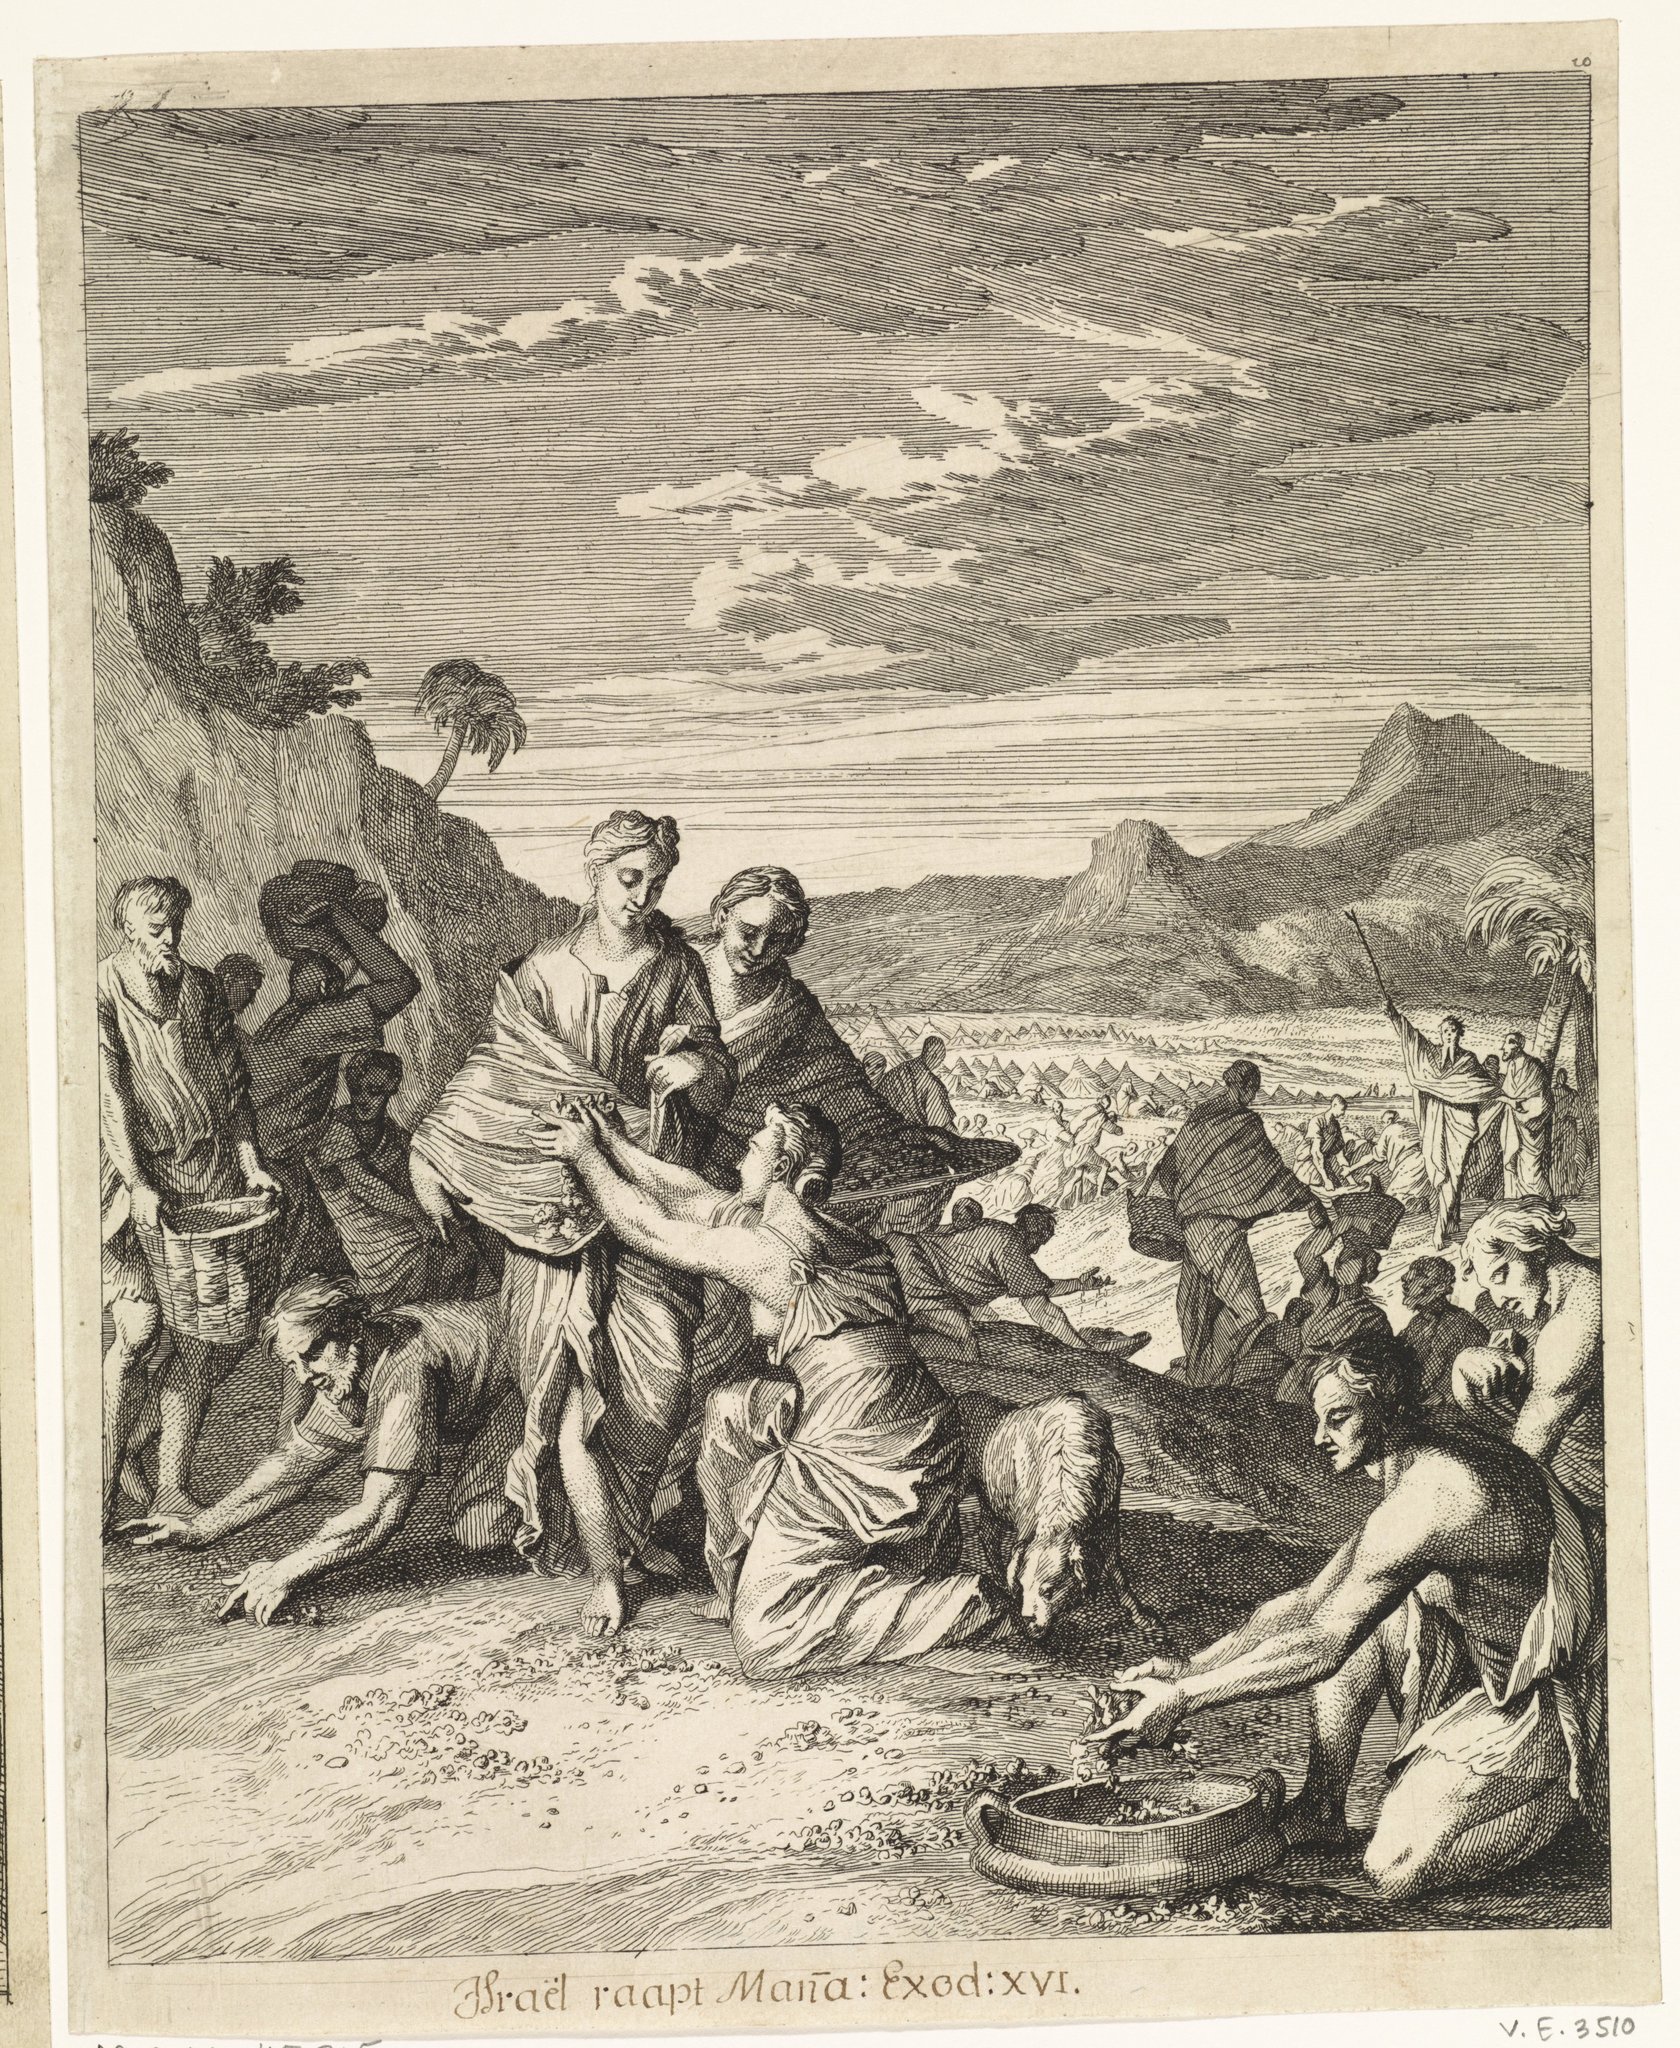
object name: print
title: Inzameling van het manna door de Israëlieten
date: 1708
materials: paper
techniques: etching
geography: amsterdam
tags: the gathering of manna (in baskets and pots)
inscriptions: collector's mark: Lugt 2228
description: Proefdruk van een prent welke is opgenomen als illustratie in: Historiae Celebriores Veteris Testamenti. Christoph Weigel, 1708.